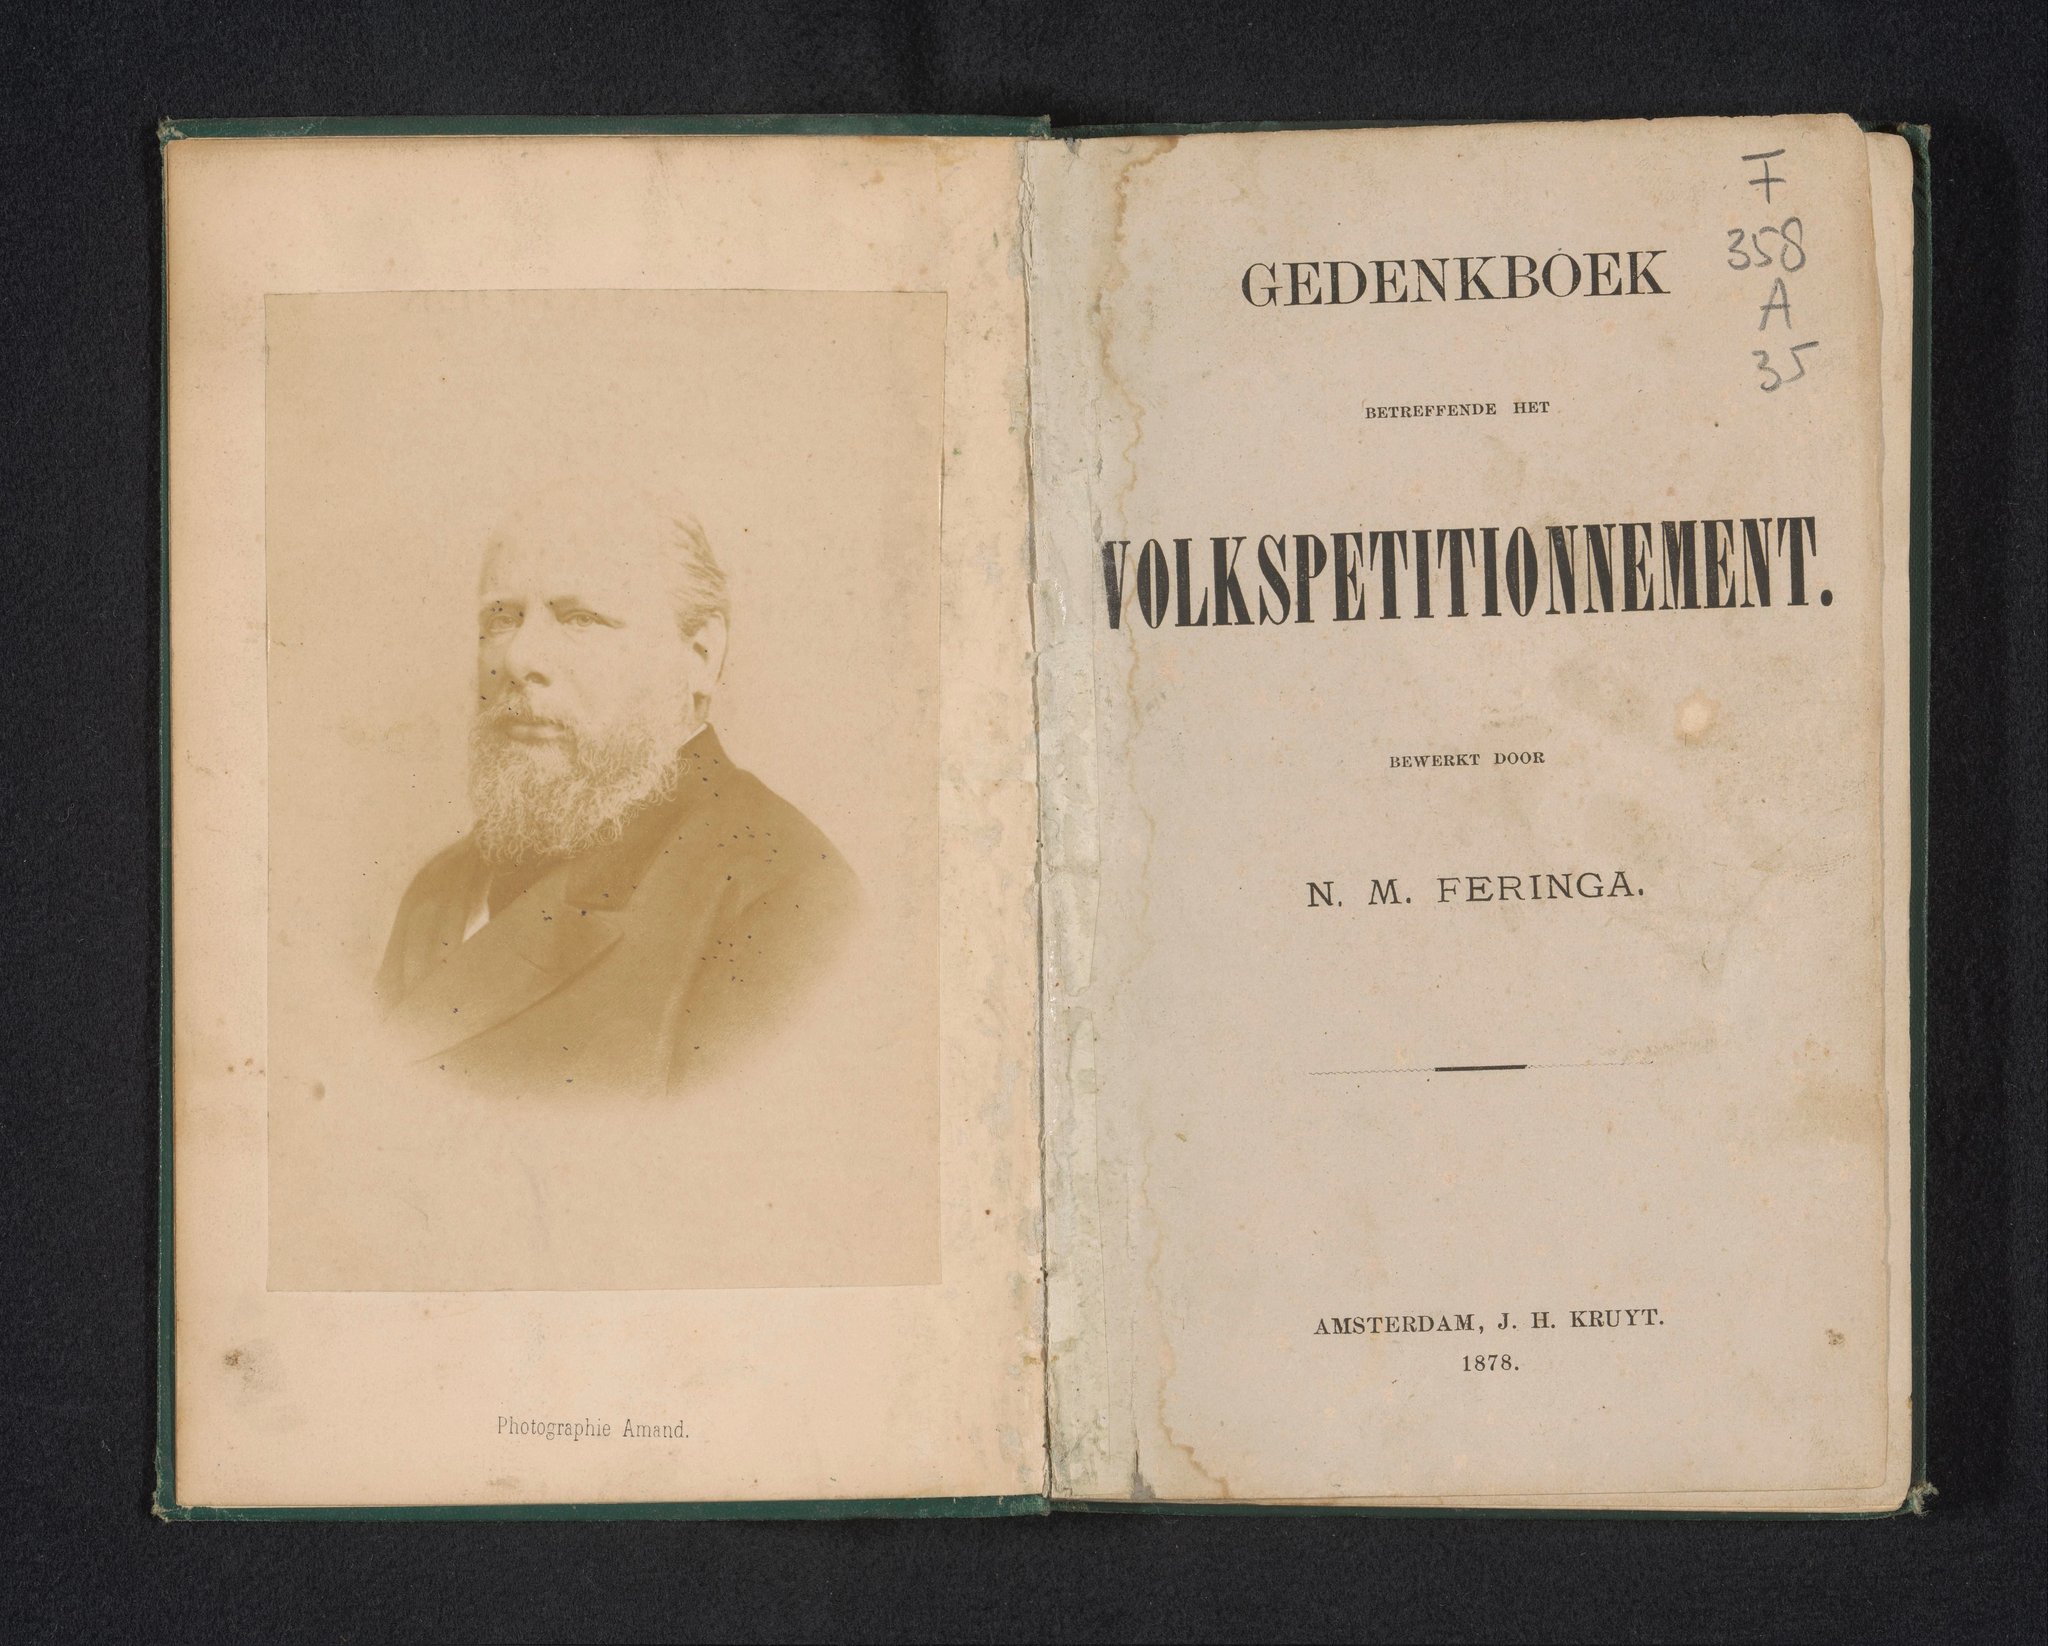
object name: book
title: Gedenkboek betreffende het volkspetitionnement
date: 1878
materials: linen, paper, photographic support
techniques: albumen print, printing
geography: amsterdam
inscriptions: date: ‘Feb 1996’, annotation: ‘75,-’